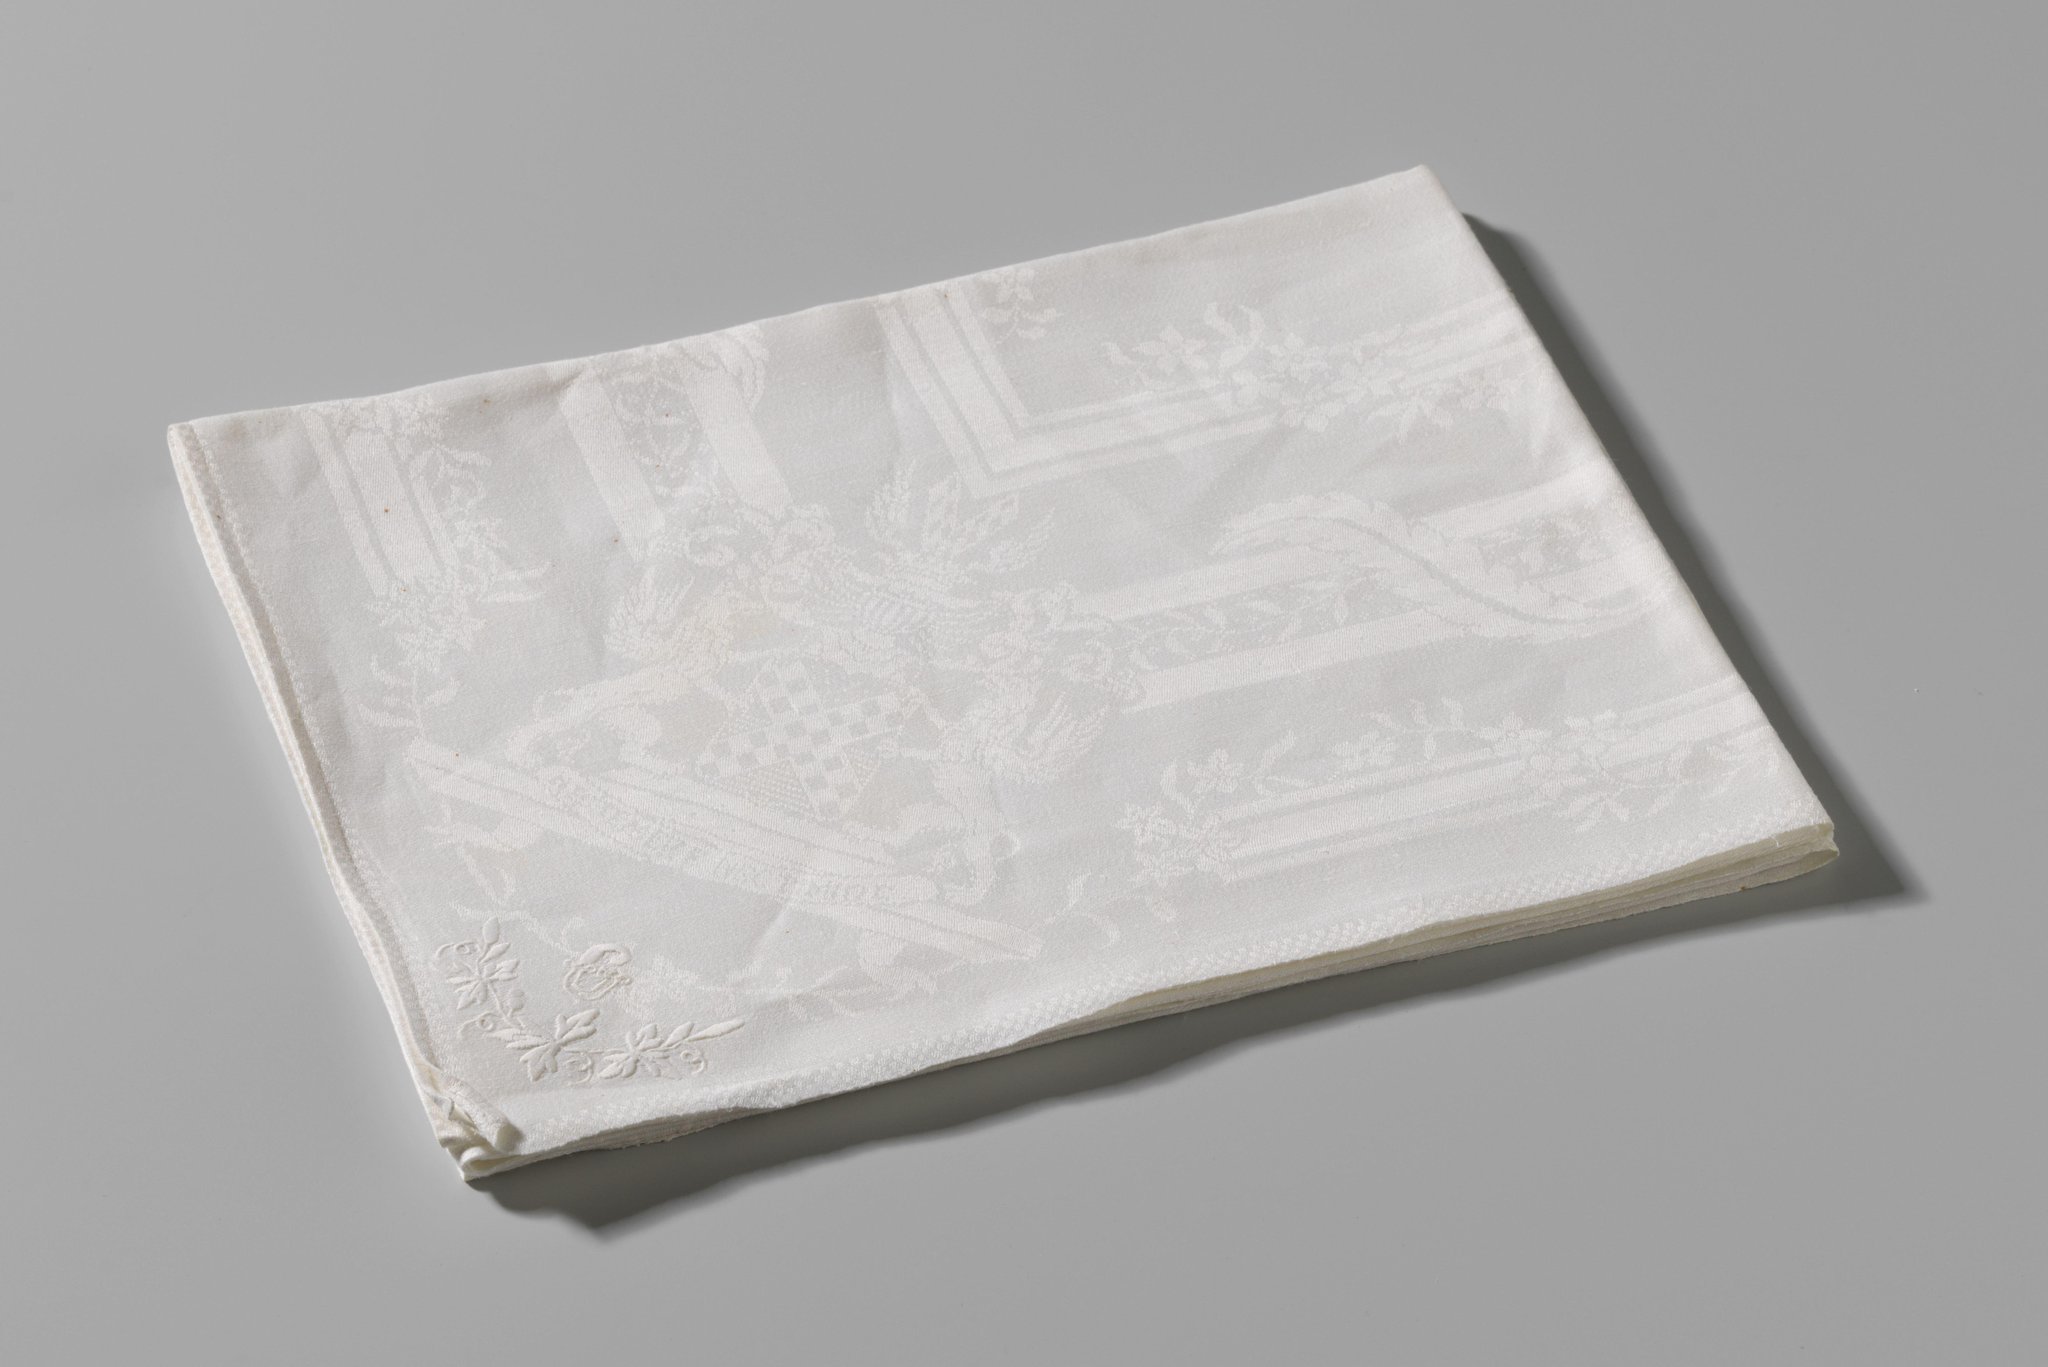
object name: napkin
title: Servet met het familiewapen Van der Dussen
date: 1870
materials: linen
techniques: damask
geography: boxtel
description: Servet van linnendamast met het familiewapen Van der Dussen. Middenveld: wapenschild temidden van gestrooide bloemknoppen. Randen: drie drievoudige banden, de middelste met een bladrank, de andere glad en omslingerd met een spiraaltak.